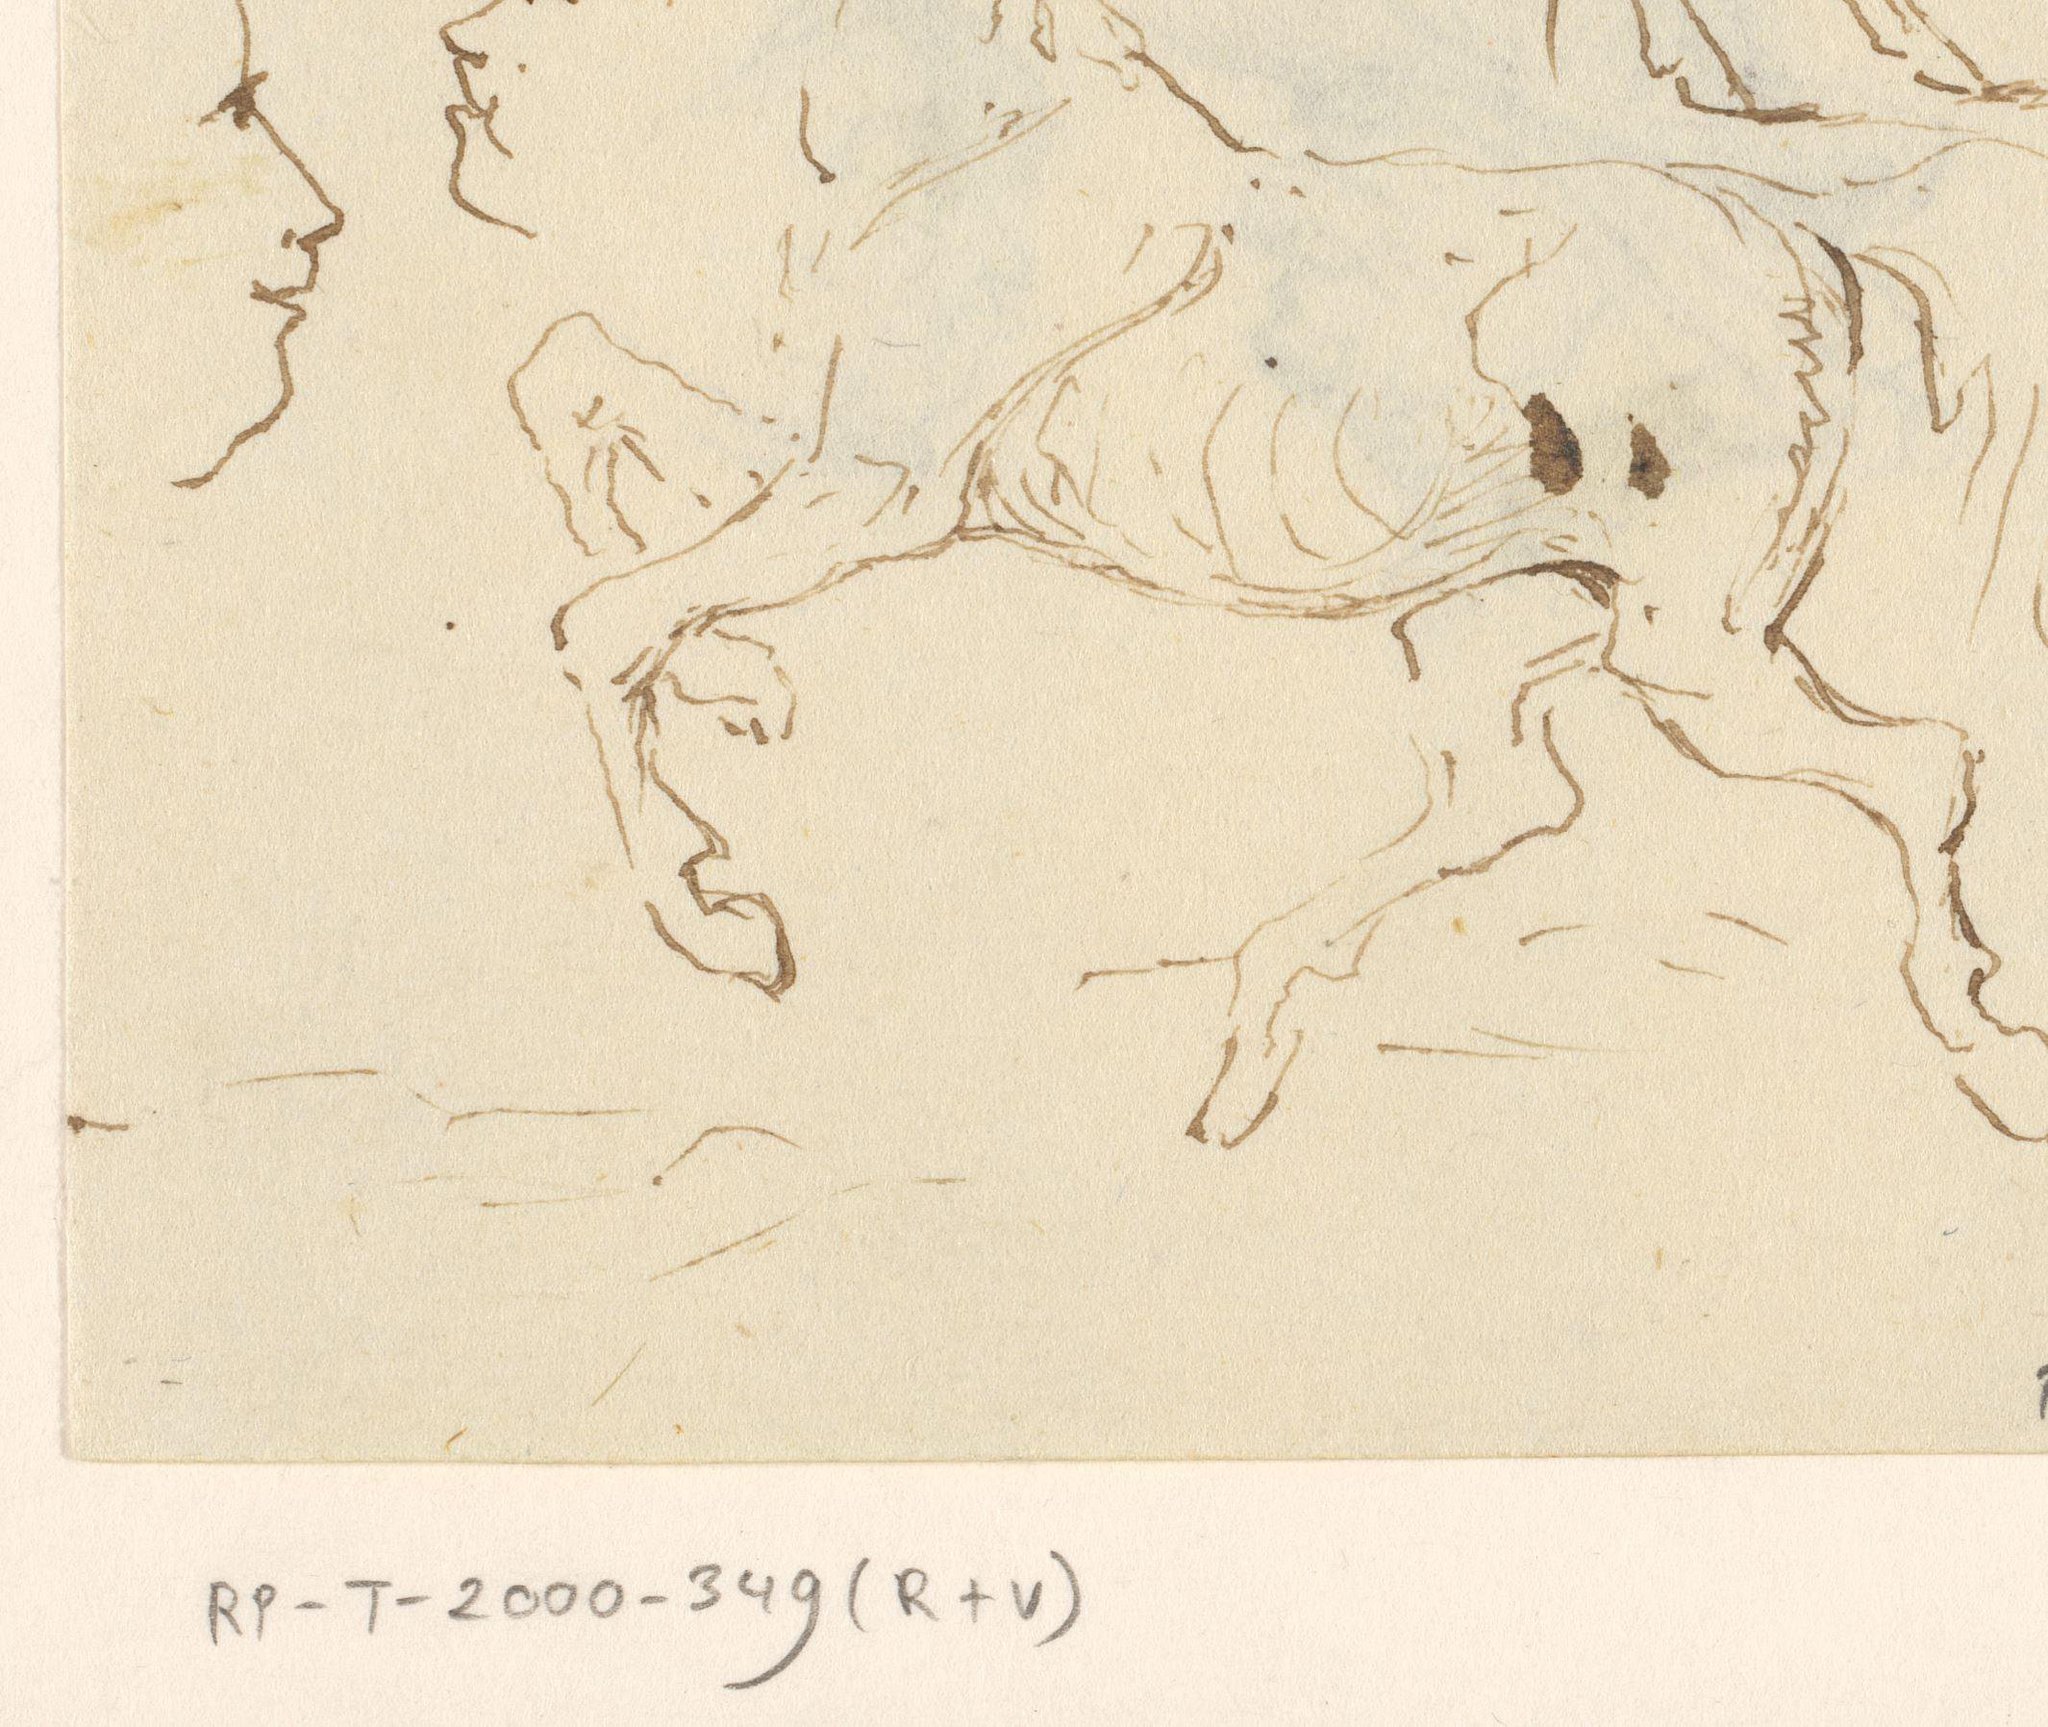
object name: drawing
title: Paarden en koppen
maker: johannes tavenraat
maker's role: draughtsman, painter, print maker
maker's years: 1809-1881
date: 1840-1880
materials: ink, paper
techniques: brush, pen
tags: caricatures (human types), horse